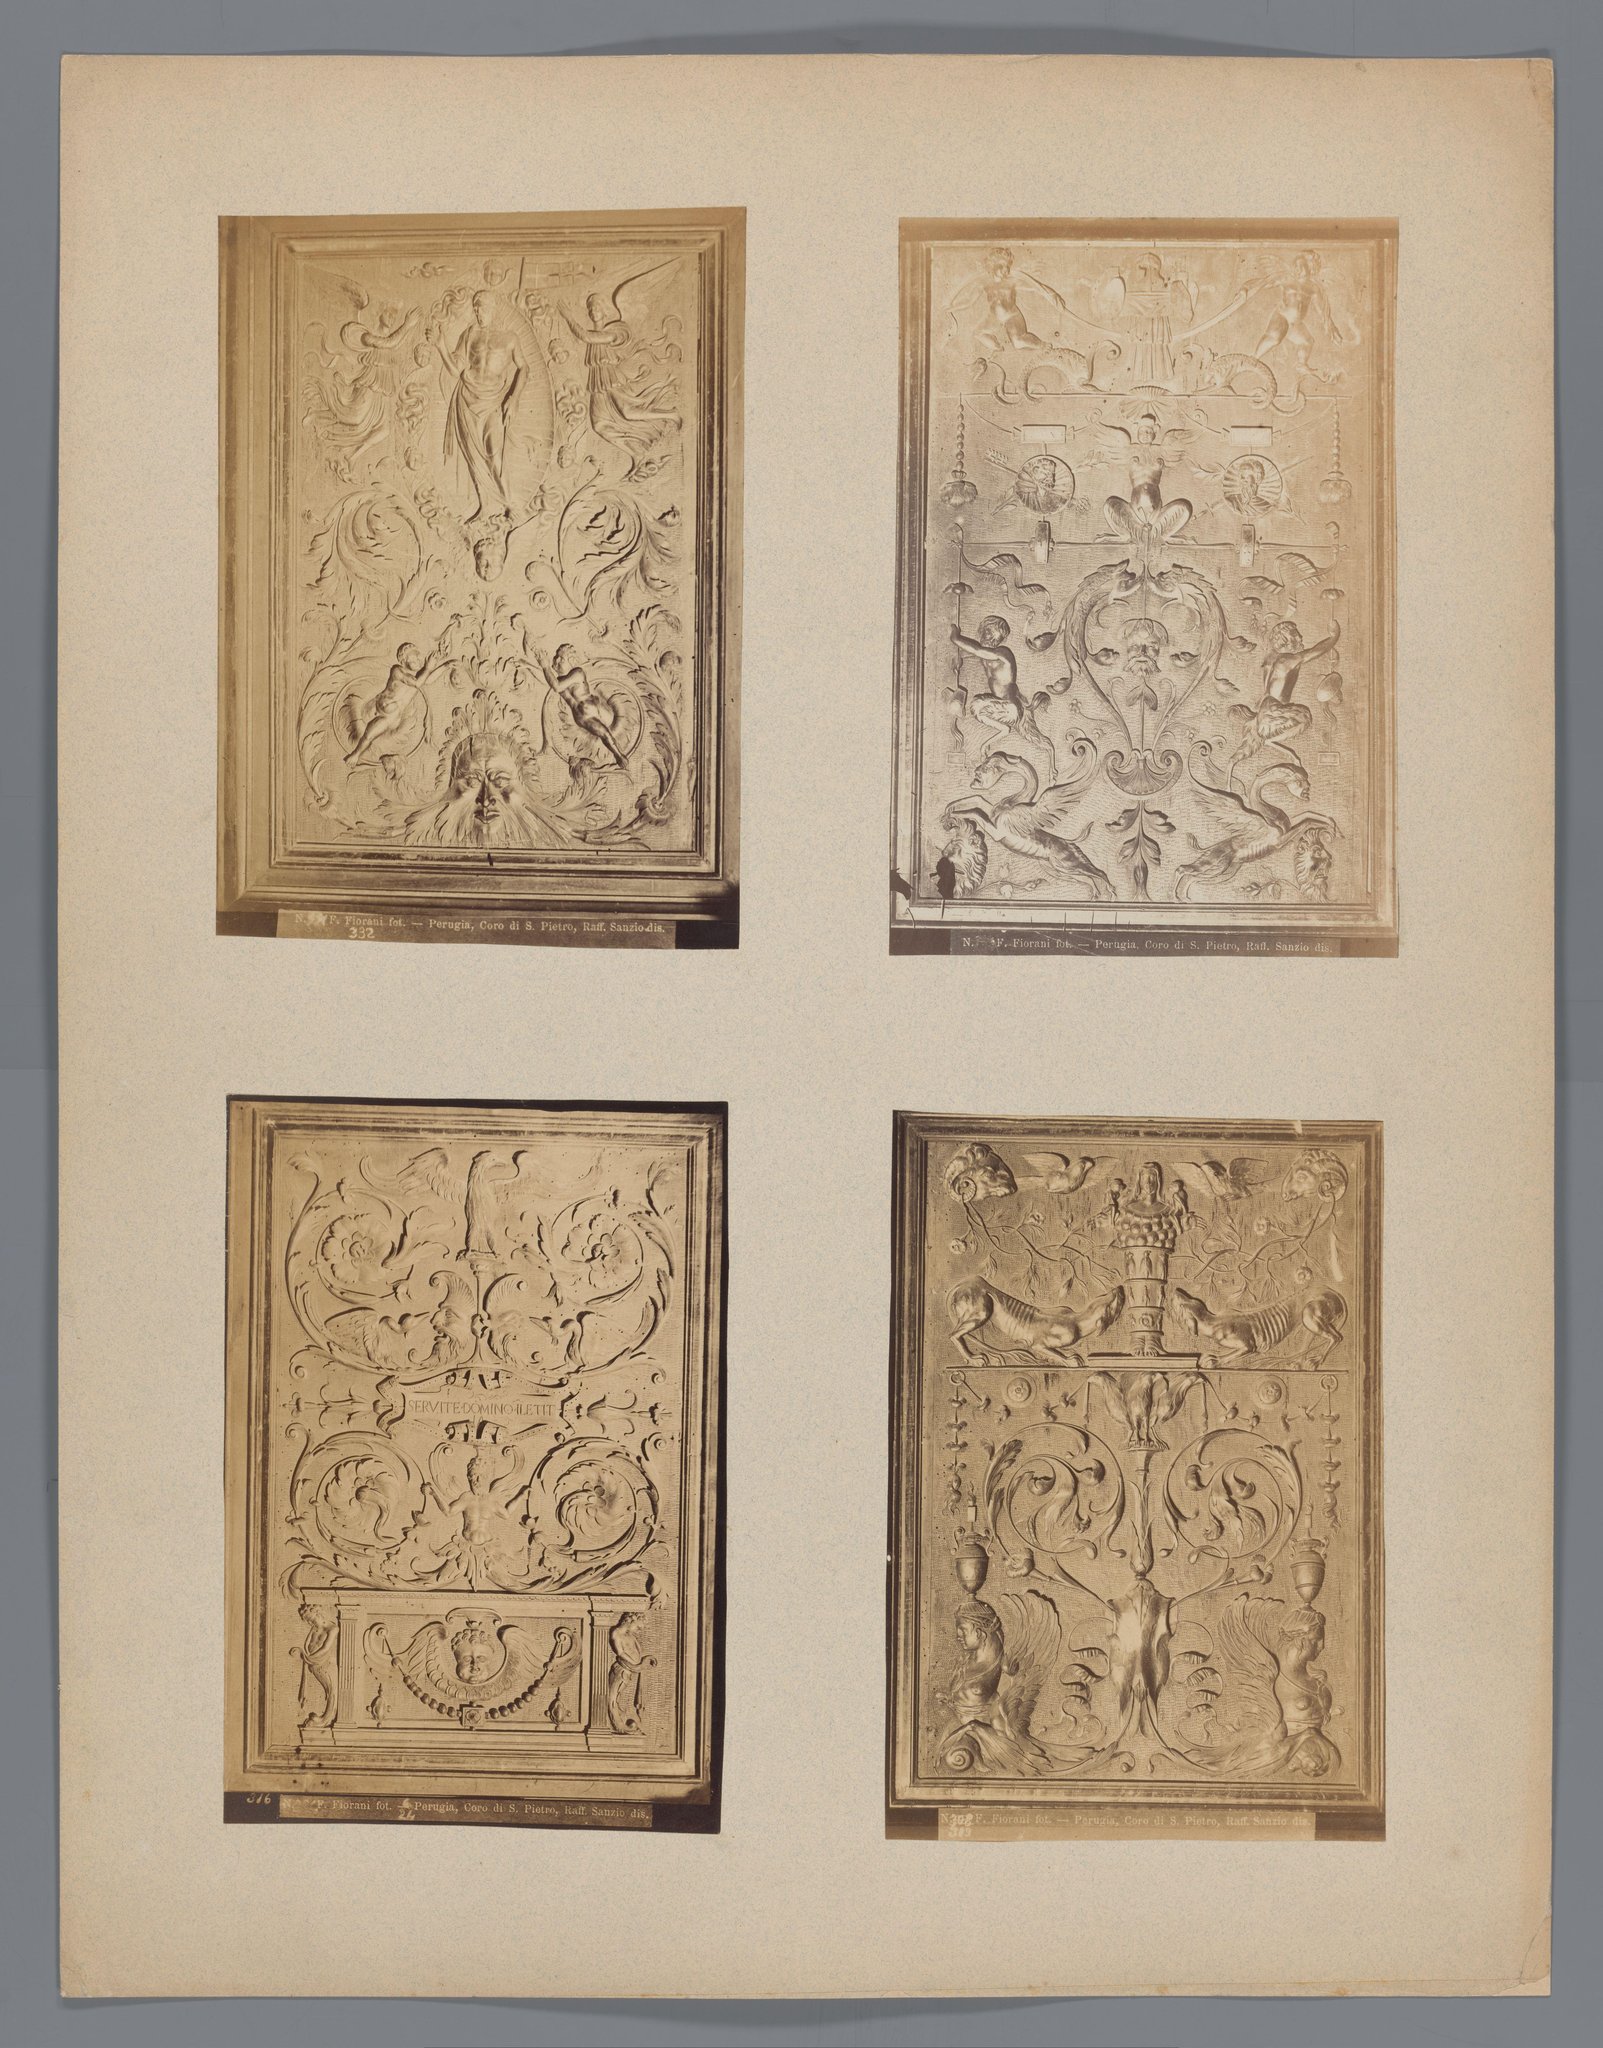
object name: photograph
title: Blad met vier foto's van reliëfs met arabesken uit het koor van de S. Pietro te Perugia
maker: f. fiorani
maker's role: fotograaf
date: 1850-1900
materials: cardboard, photographic support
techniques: albumen print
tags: decorating 'en relief', appliquéing, parts of church interior: choir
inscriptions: : ‘316 N.F. Fiorani fot. _ Perugia, Coro di S. Pietro, Raff. Sanzio dis. / 24’, : ‘N.F. Fiorani fot. _ Perugia, Coro di S. Pietro, Raff. Sanzio dis. / 332’, : ‘N.F. Fiorani fot. _ Perugia, Coro di S. Pietro, Raff. Sanzio / 319’